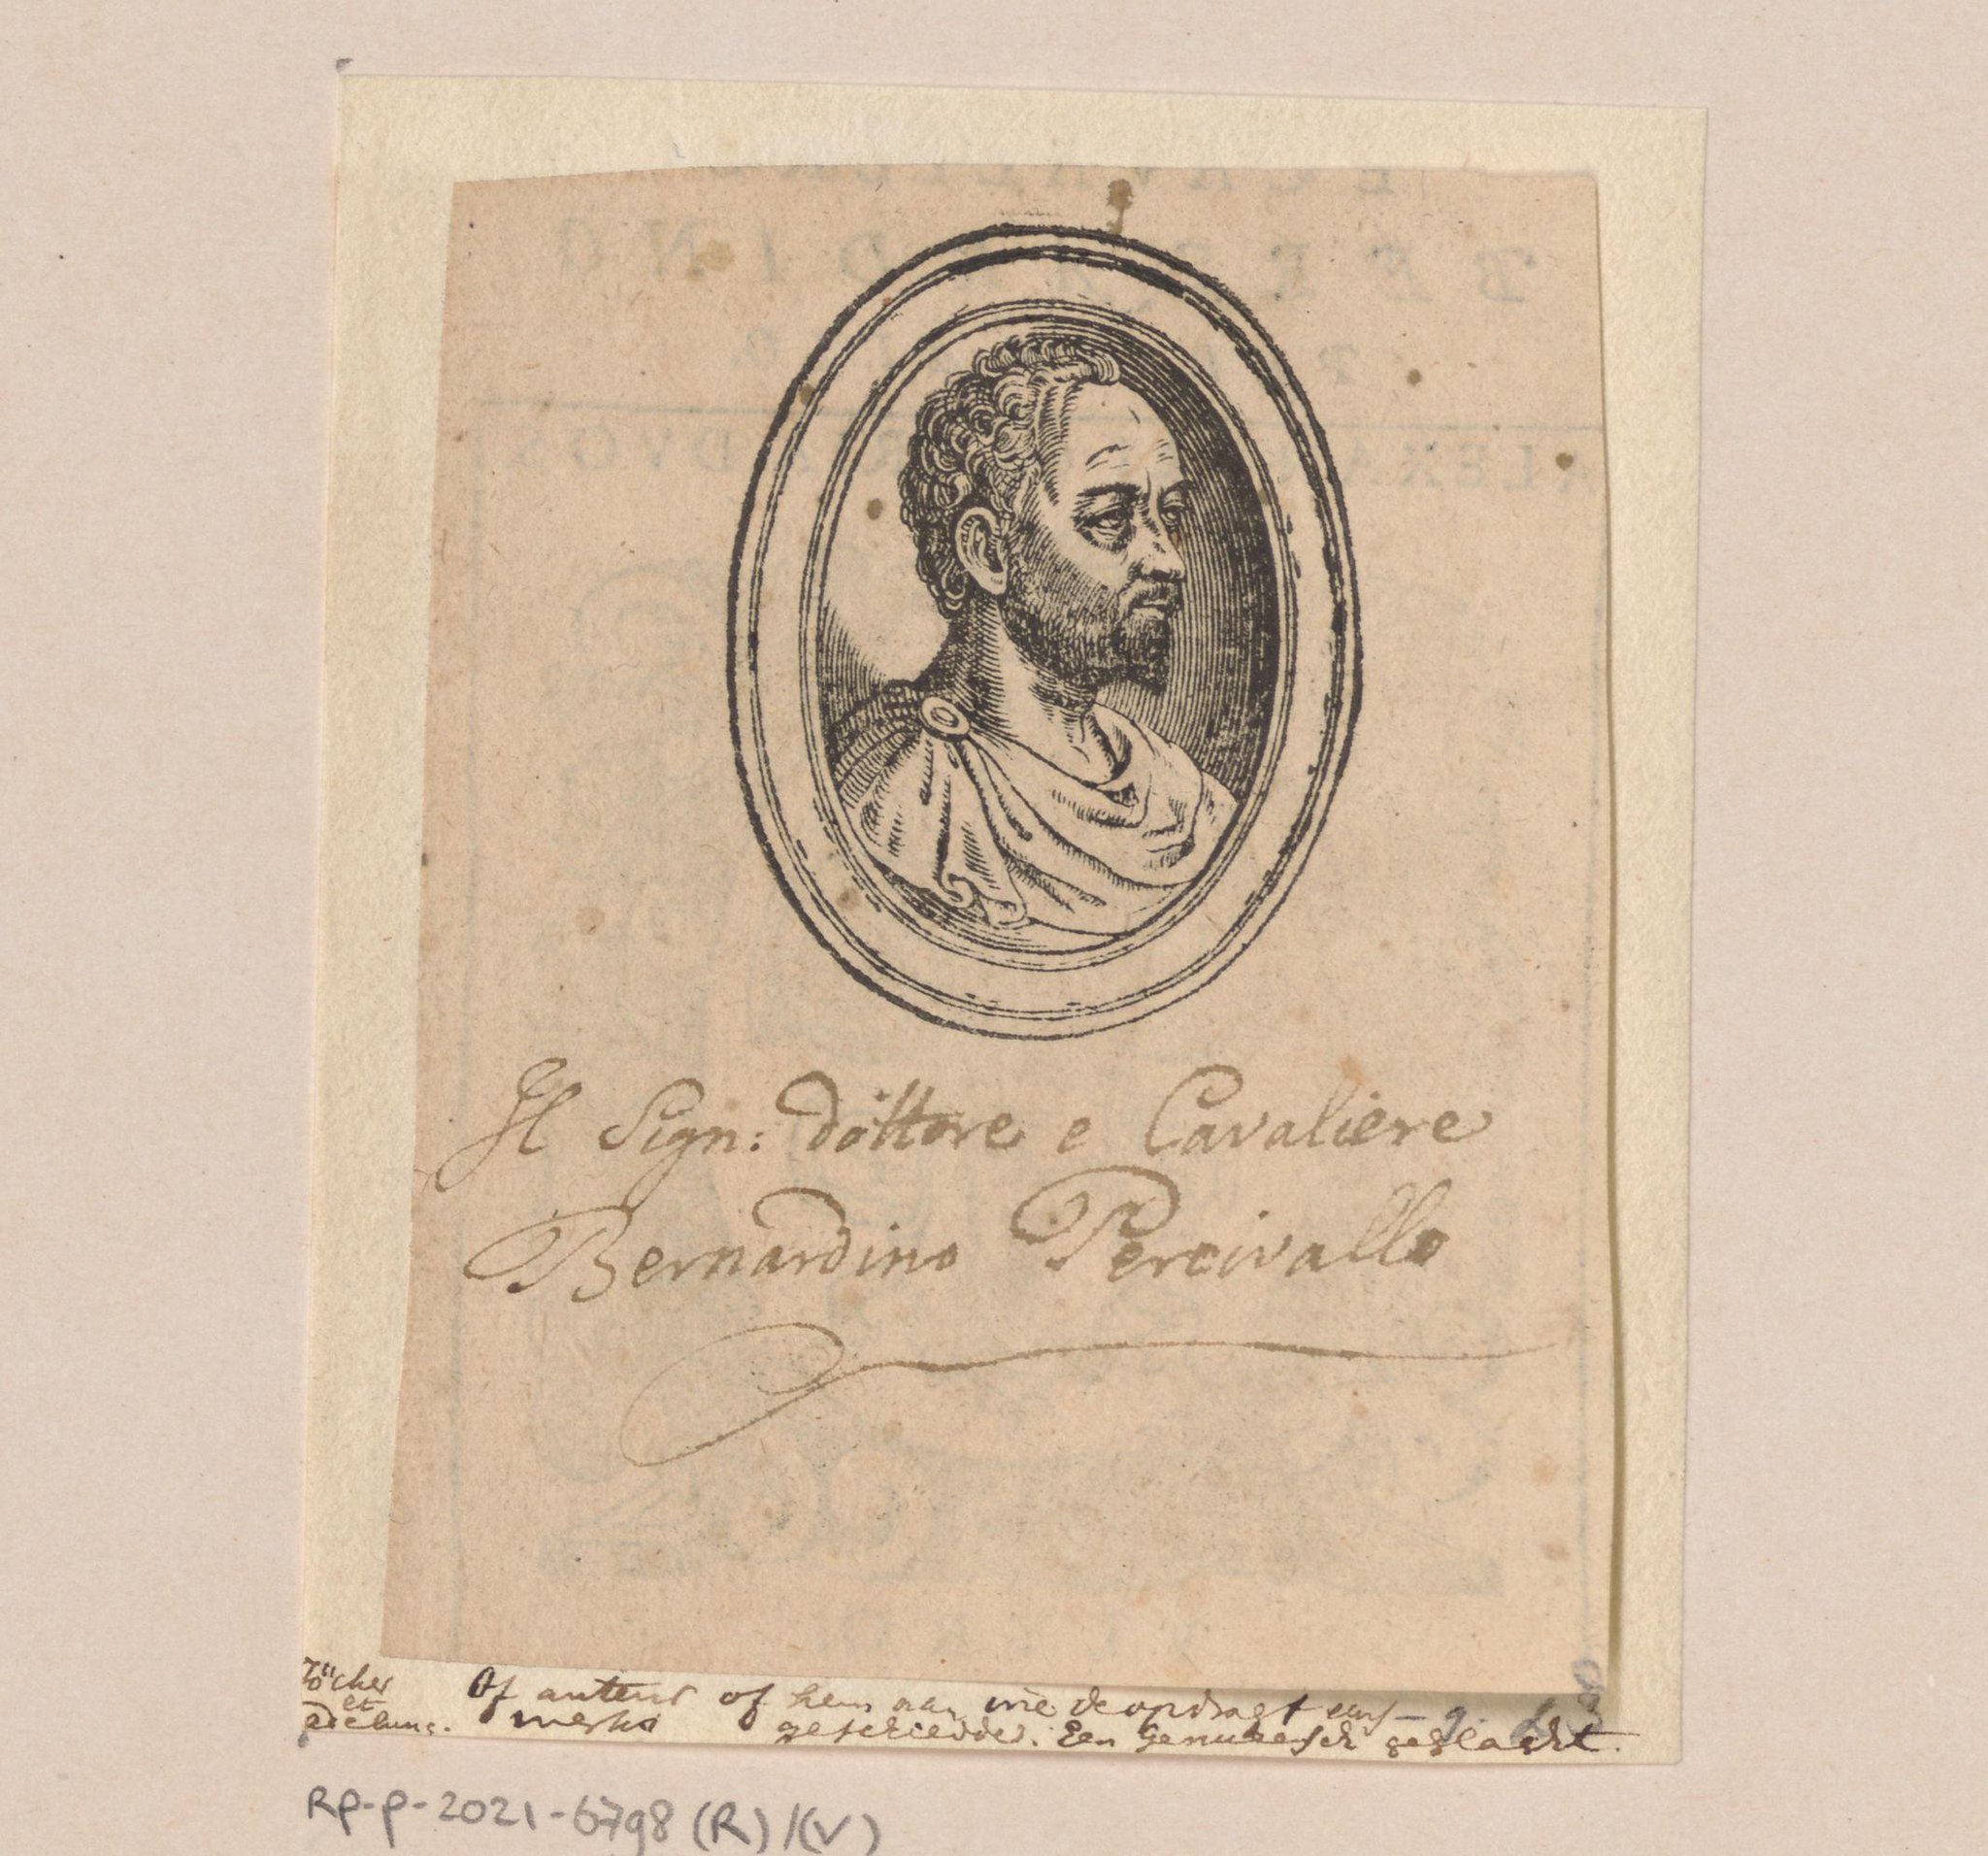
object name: book illustration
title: Wapenschild van Bernardino Percivallo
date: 1588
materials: paper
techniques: letterpress printing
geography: ferrara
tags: armorial bearing, heraldry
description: Prent uit: Percivallo, Bernardino. Rime et imprese del sig. dottore, e caualiere Bernardino Percivallo. Ferrara: Vittorio Baldini, 1588.